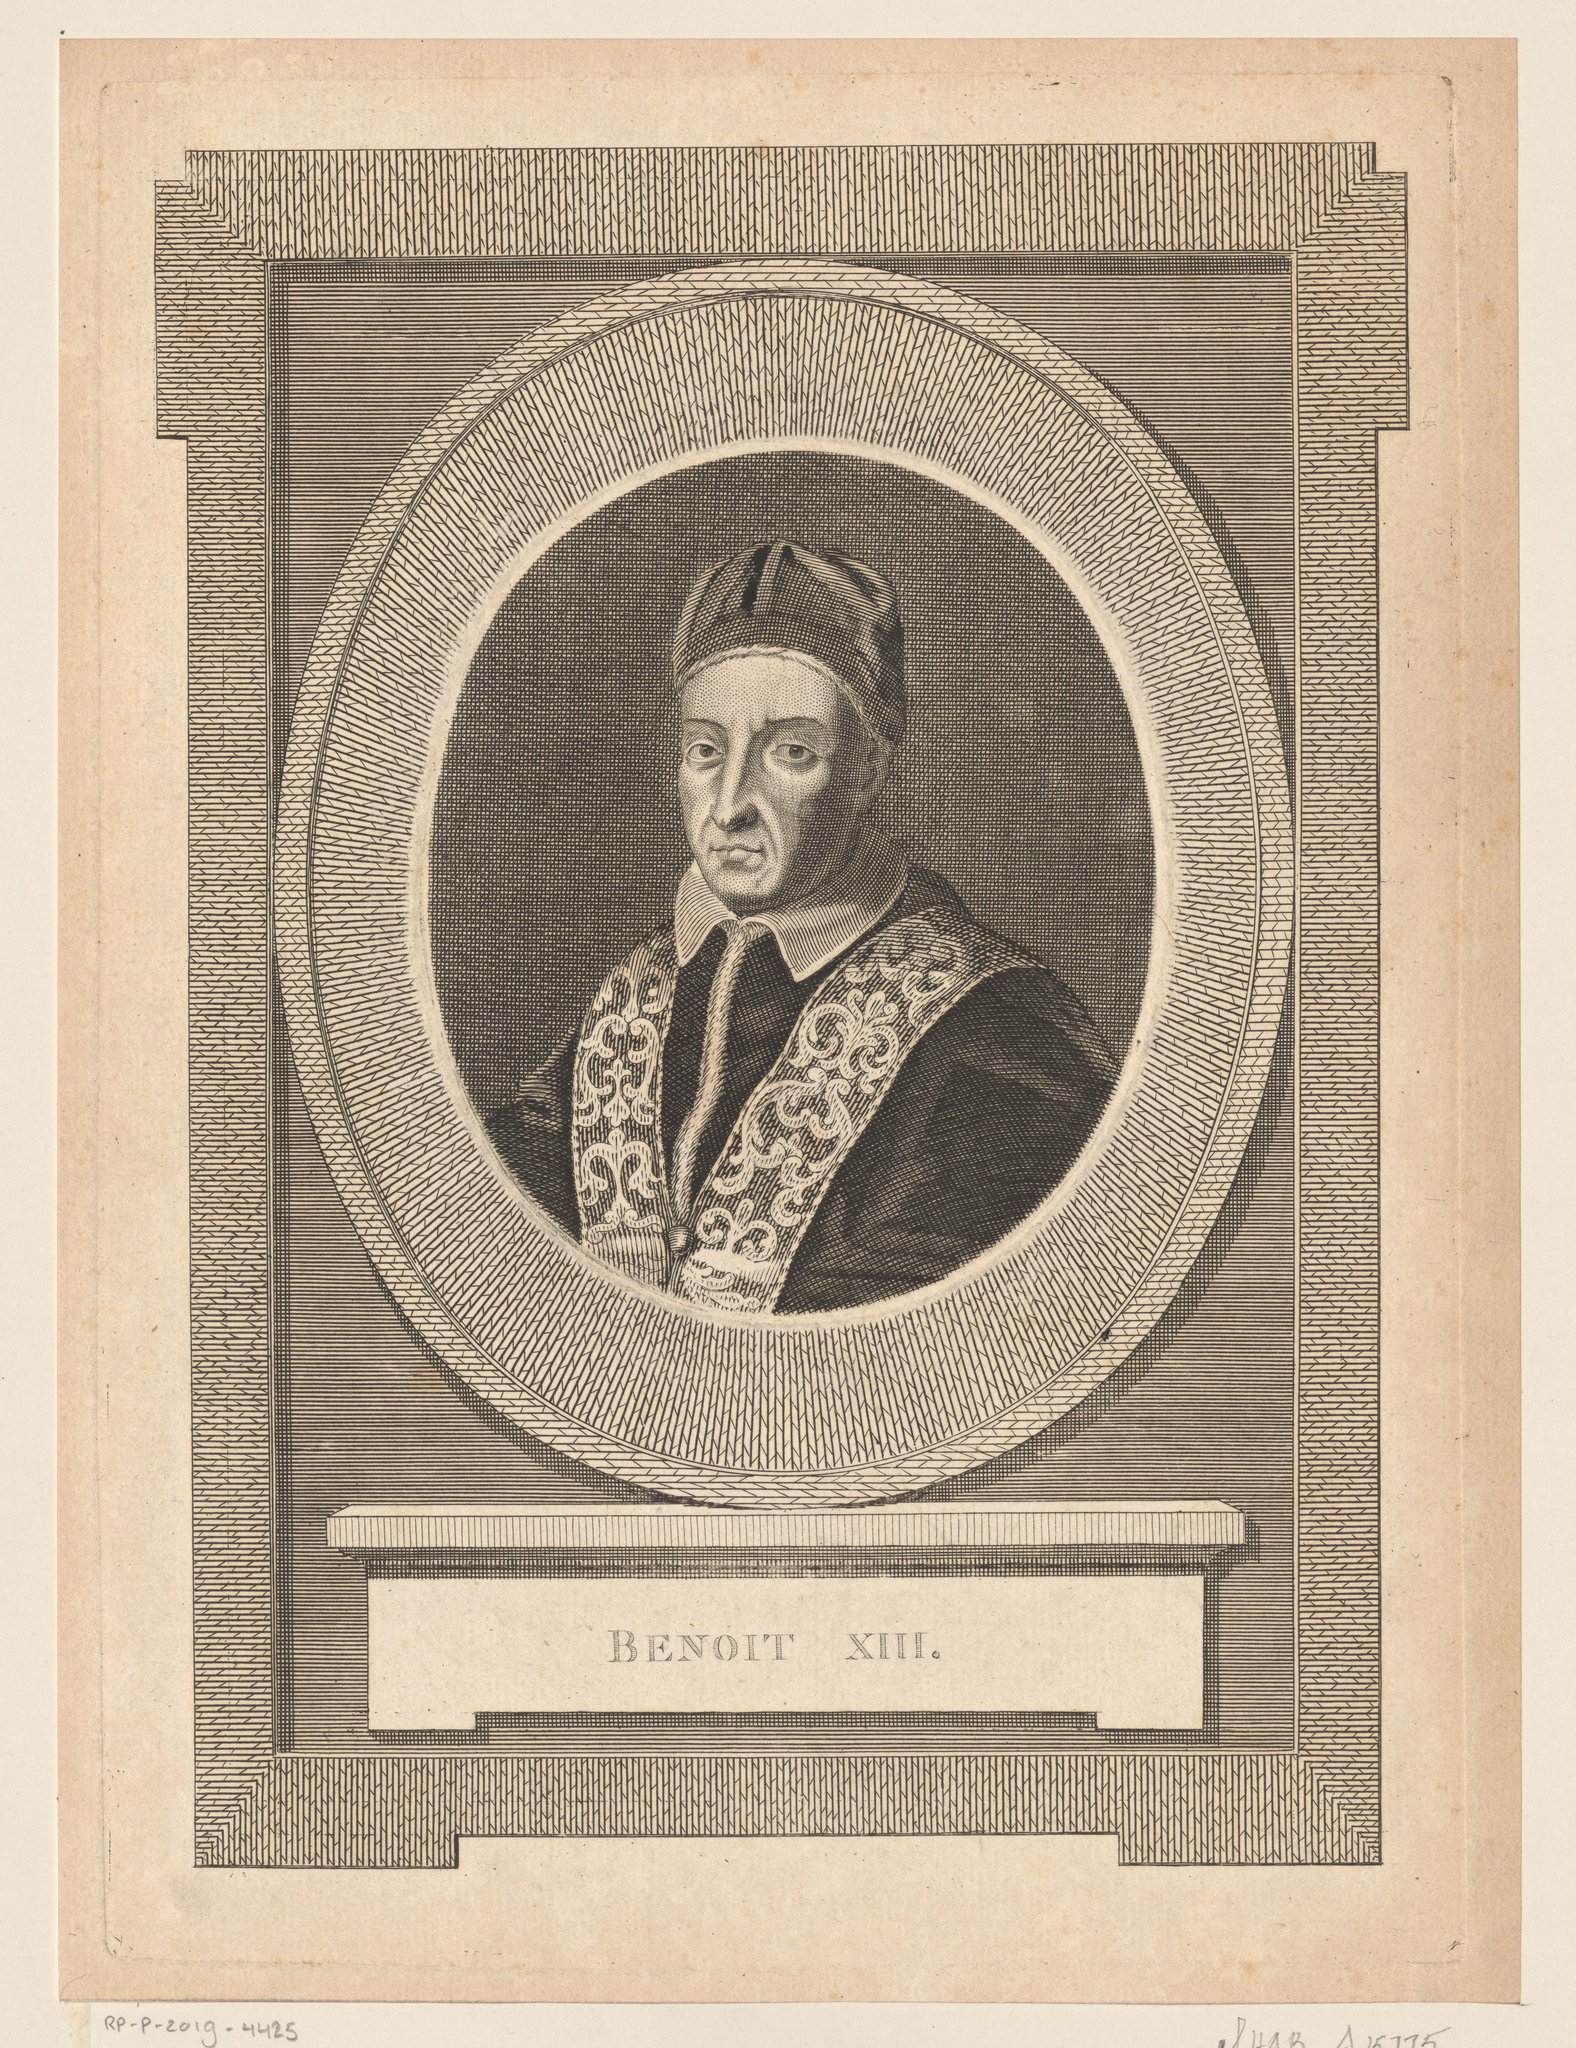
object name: print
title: Portret van paus Benedictus XIII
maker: Anonymous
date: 1724-1749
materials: paper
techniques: engraving, etching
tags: benedictus xiii, historical persons, pope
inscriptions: collector's mark: Lugt 2228